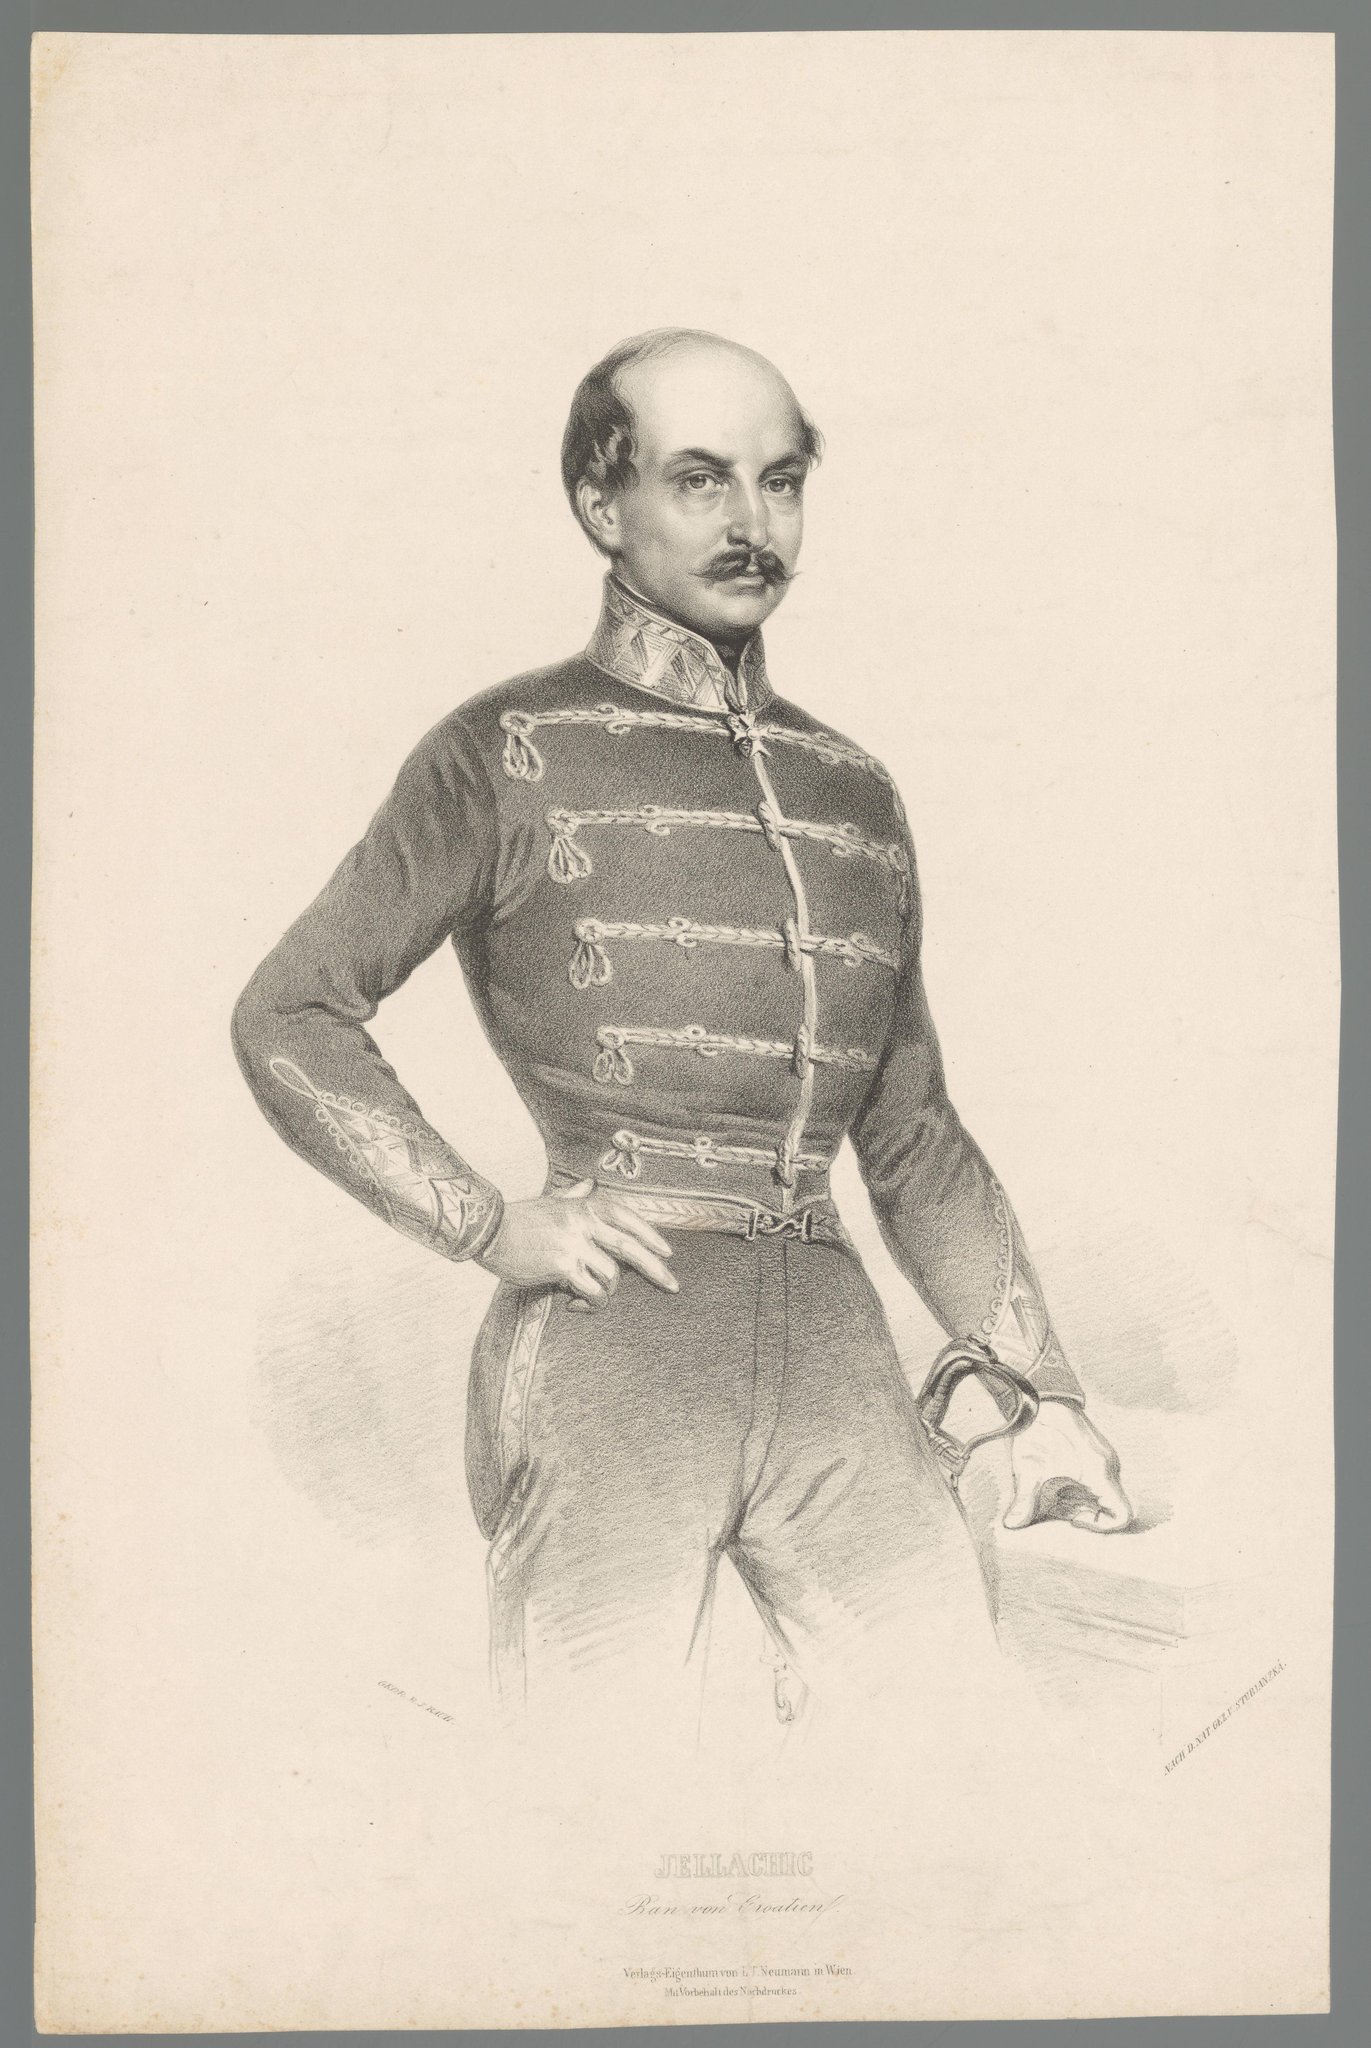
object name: print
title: Jellachic, Ran von Croatien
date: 1820-1860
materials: paper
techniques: lithograph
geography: vienna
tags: moustache, adult man, historical persons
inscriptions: collector's mark: Lugt 2228